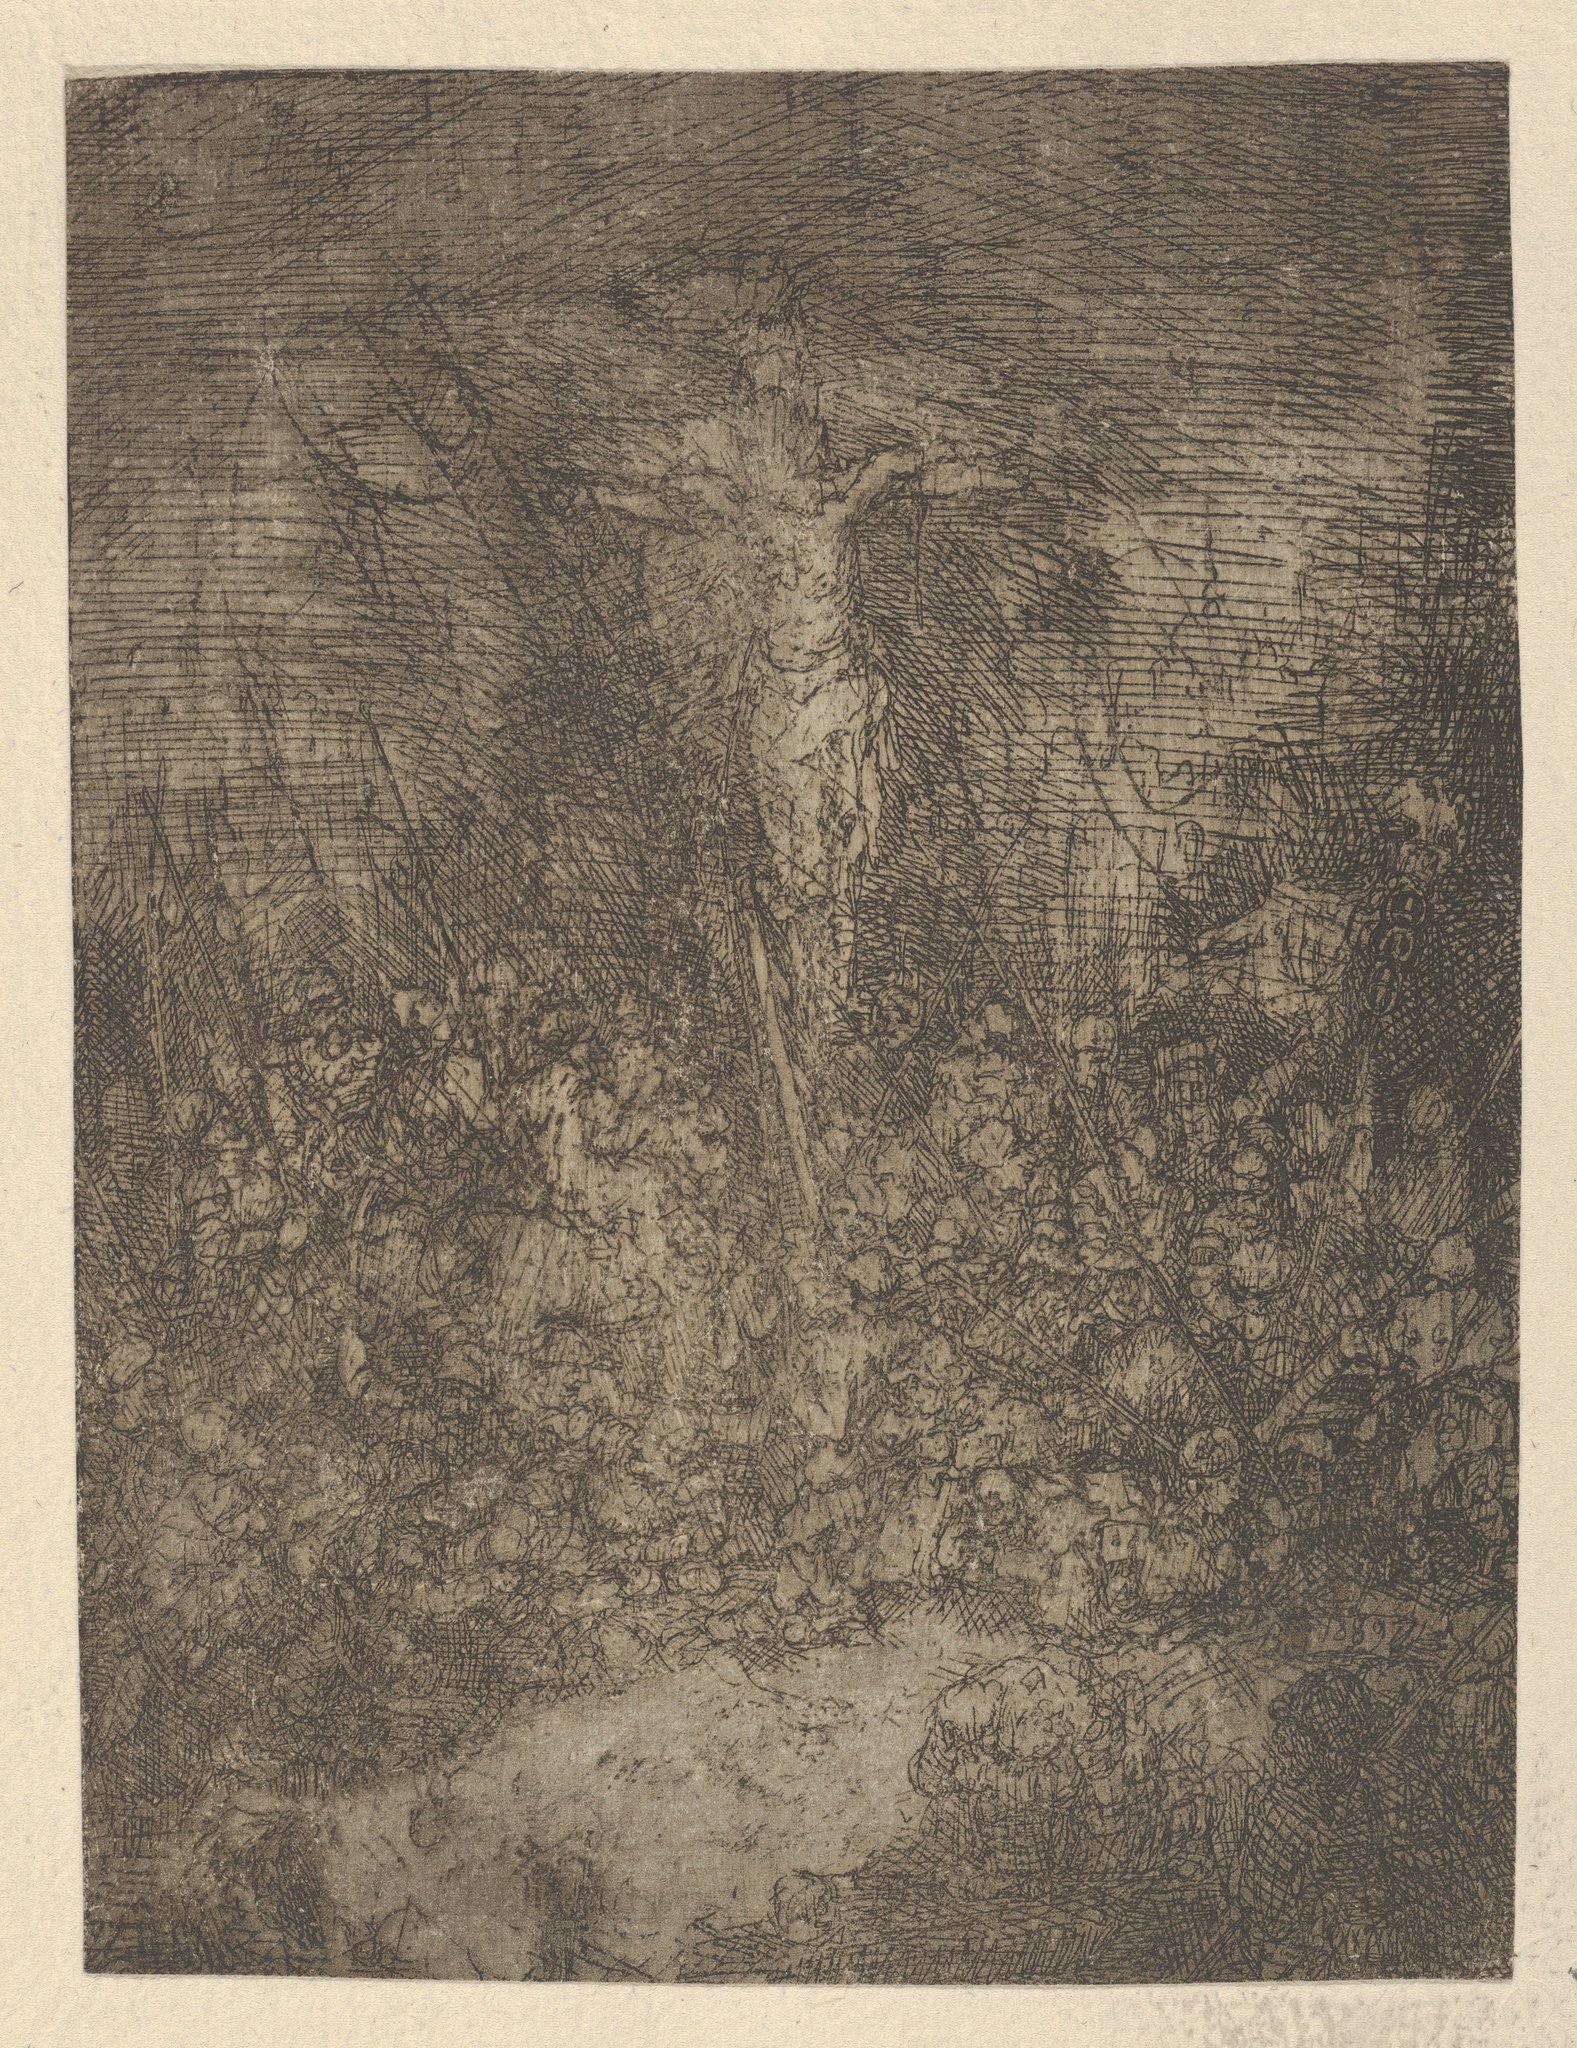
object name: print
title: La Crucifixion (The Crucifixion)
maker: rodolphe bresdin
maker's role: artist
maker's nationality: french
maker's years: 1822-1885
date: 1801-1900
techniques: etching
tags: christ,crucifixion